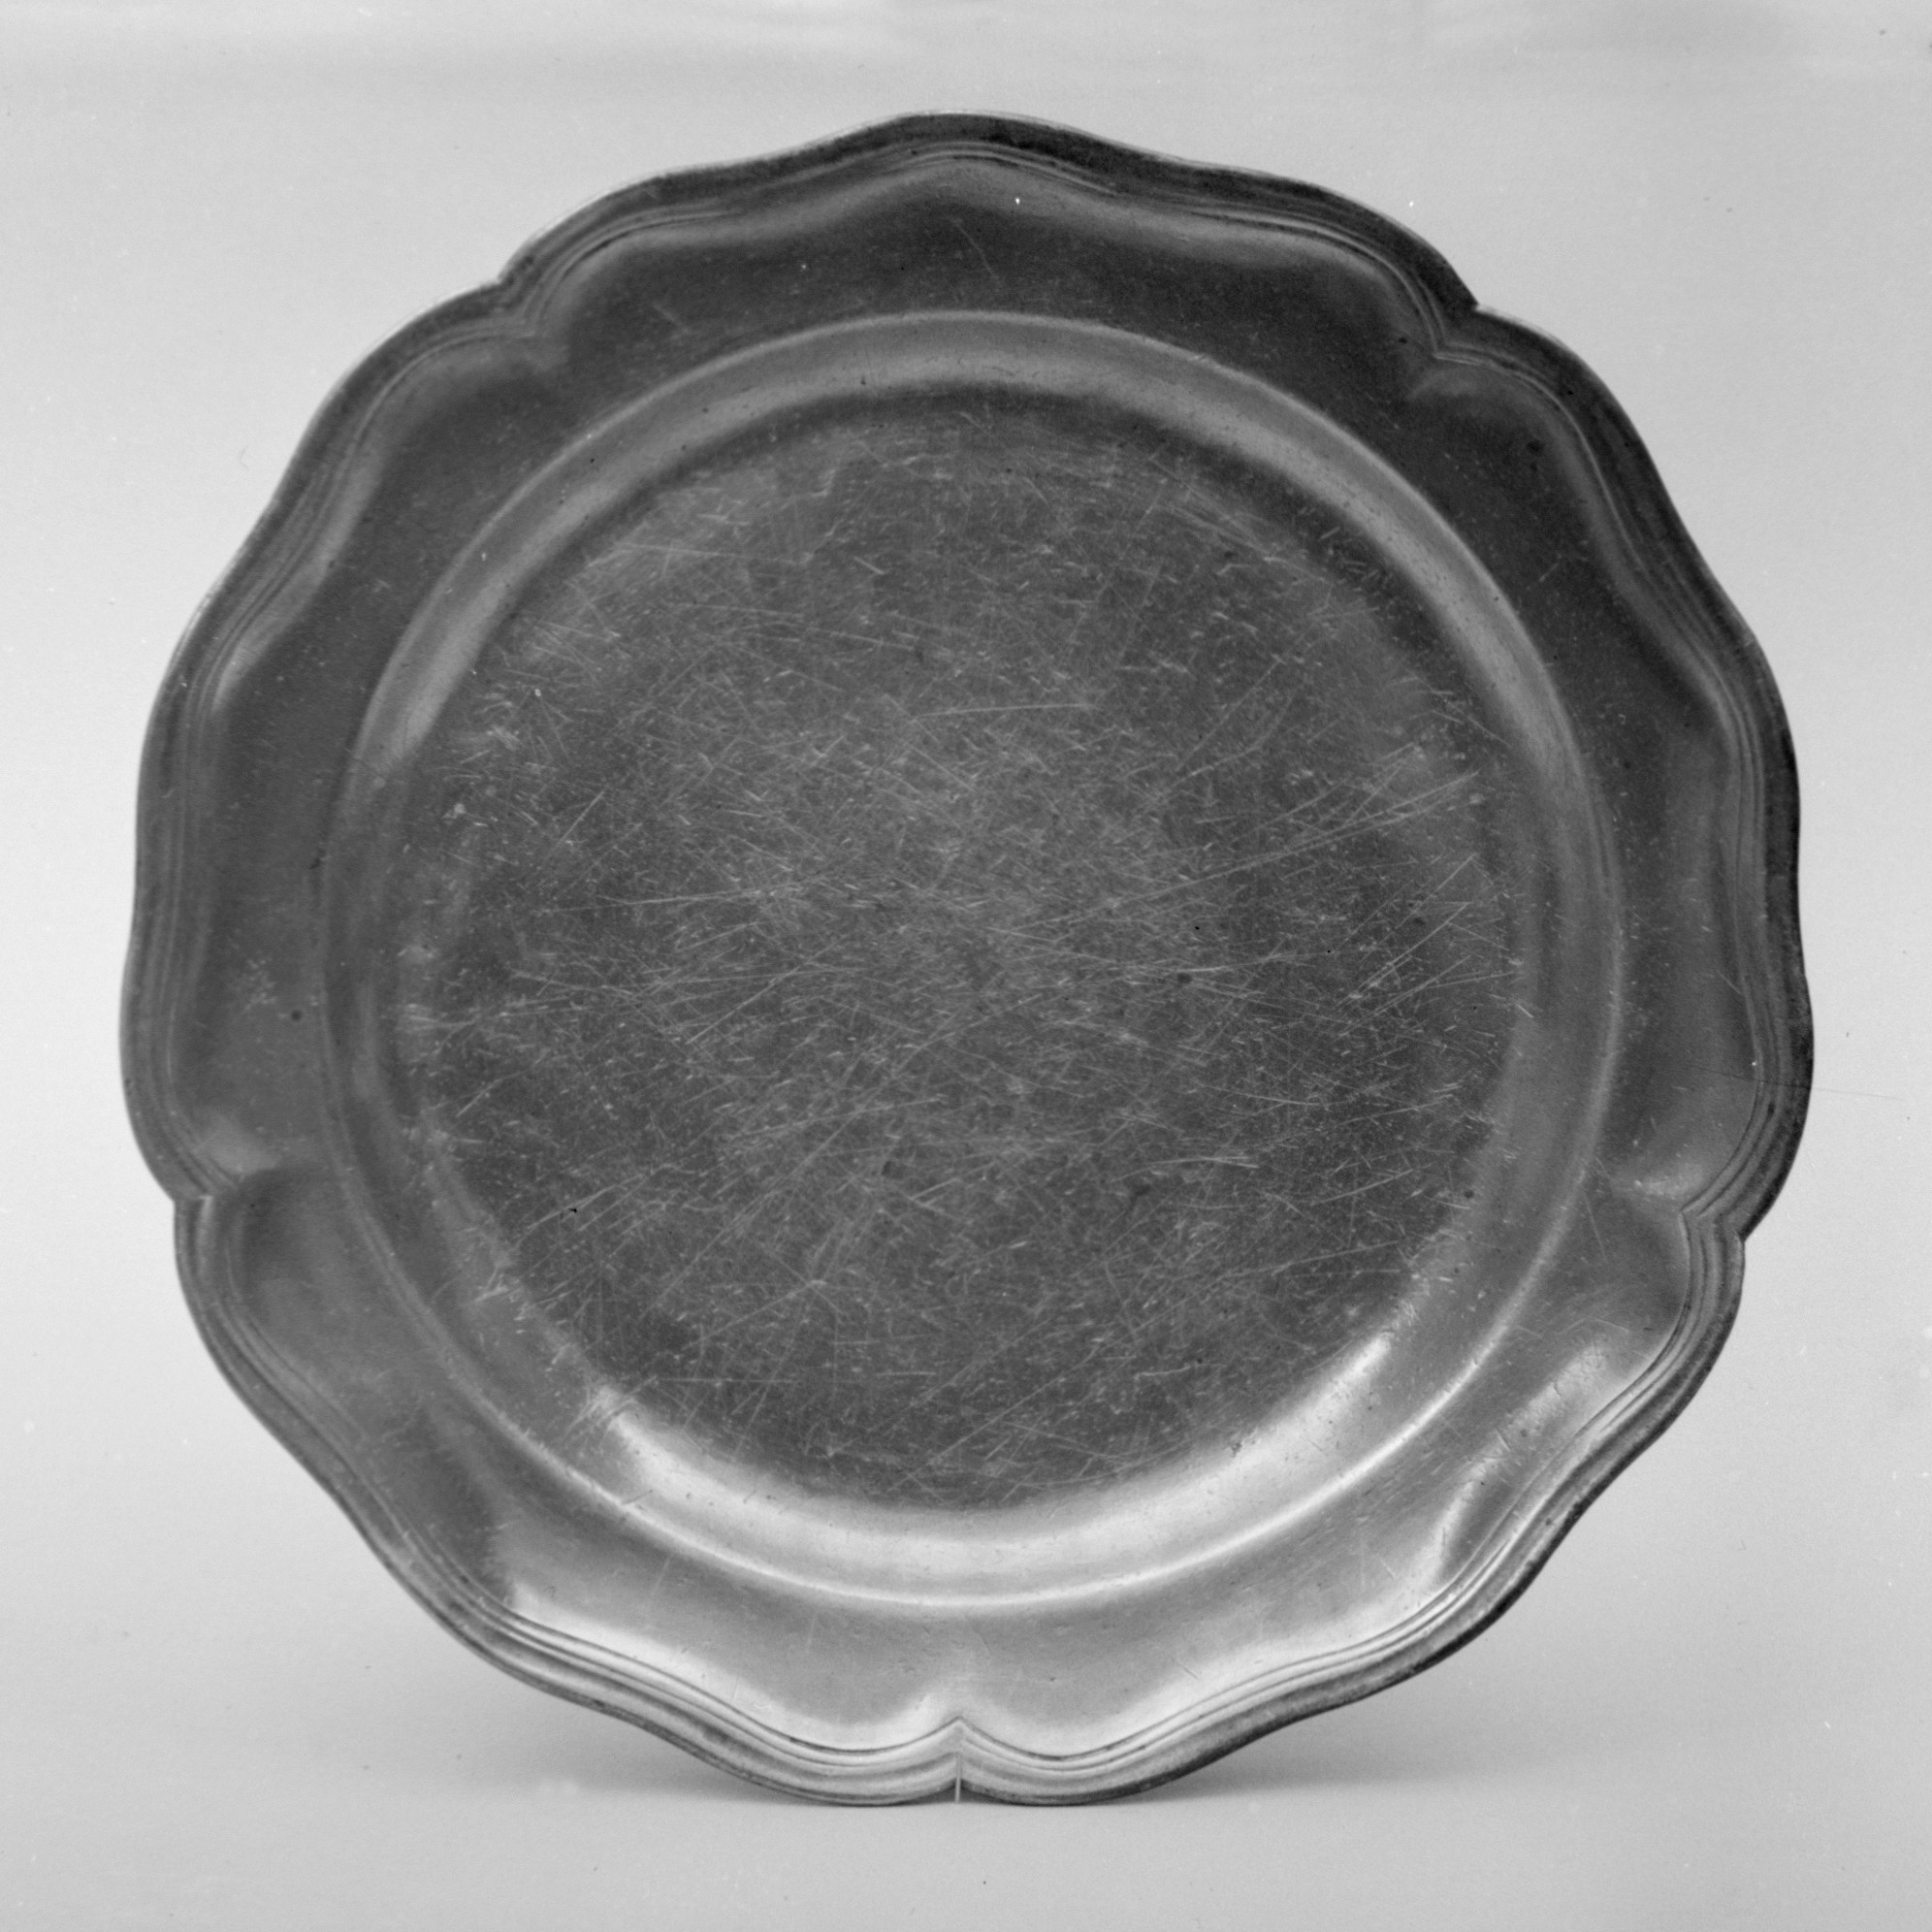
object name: plate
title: Pair of plates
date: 1701-1800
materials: pewter